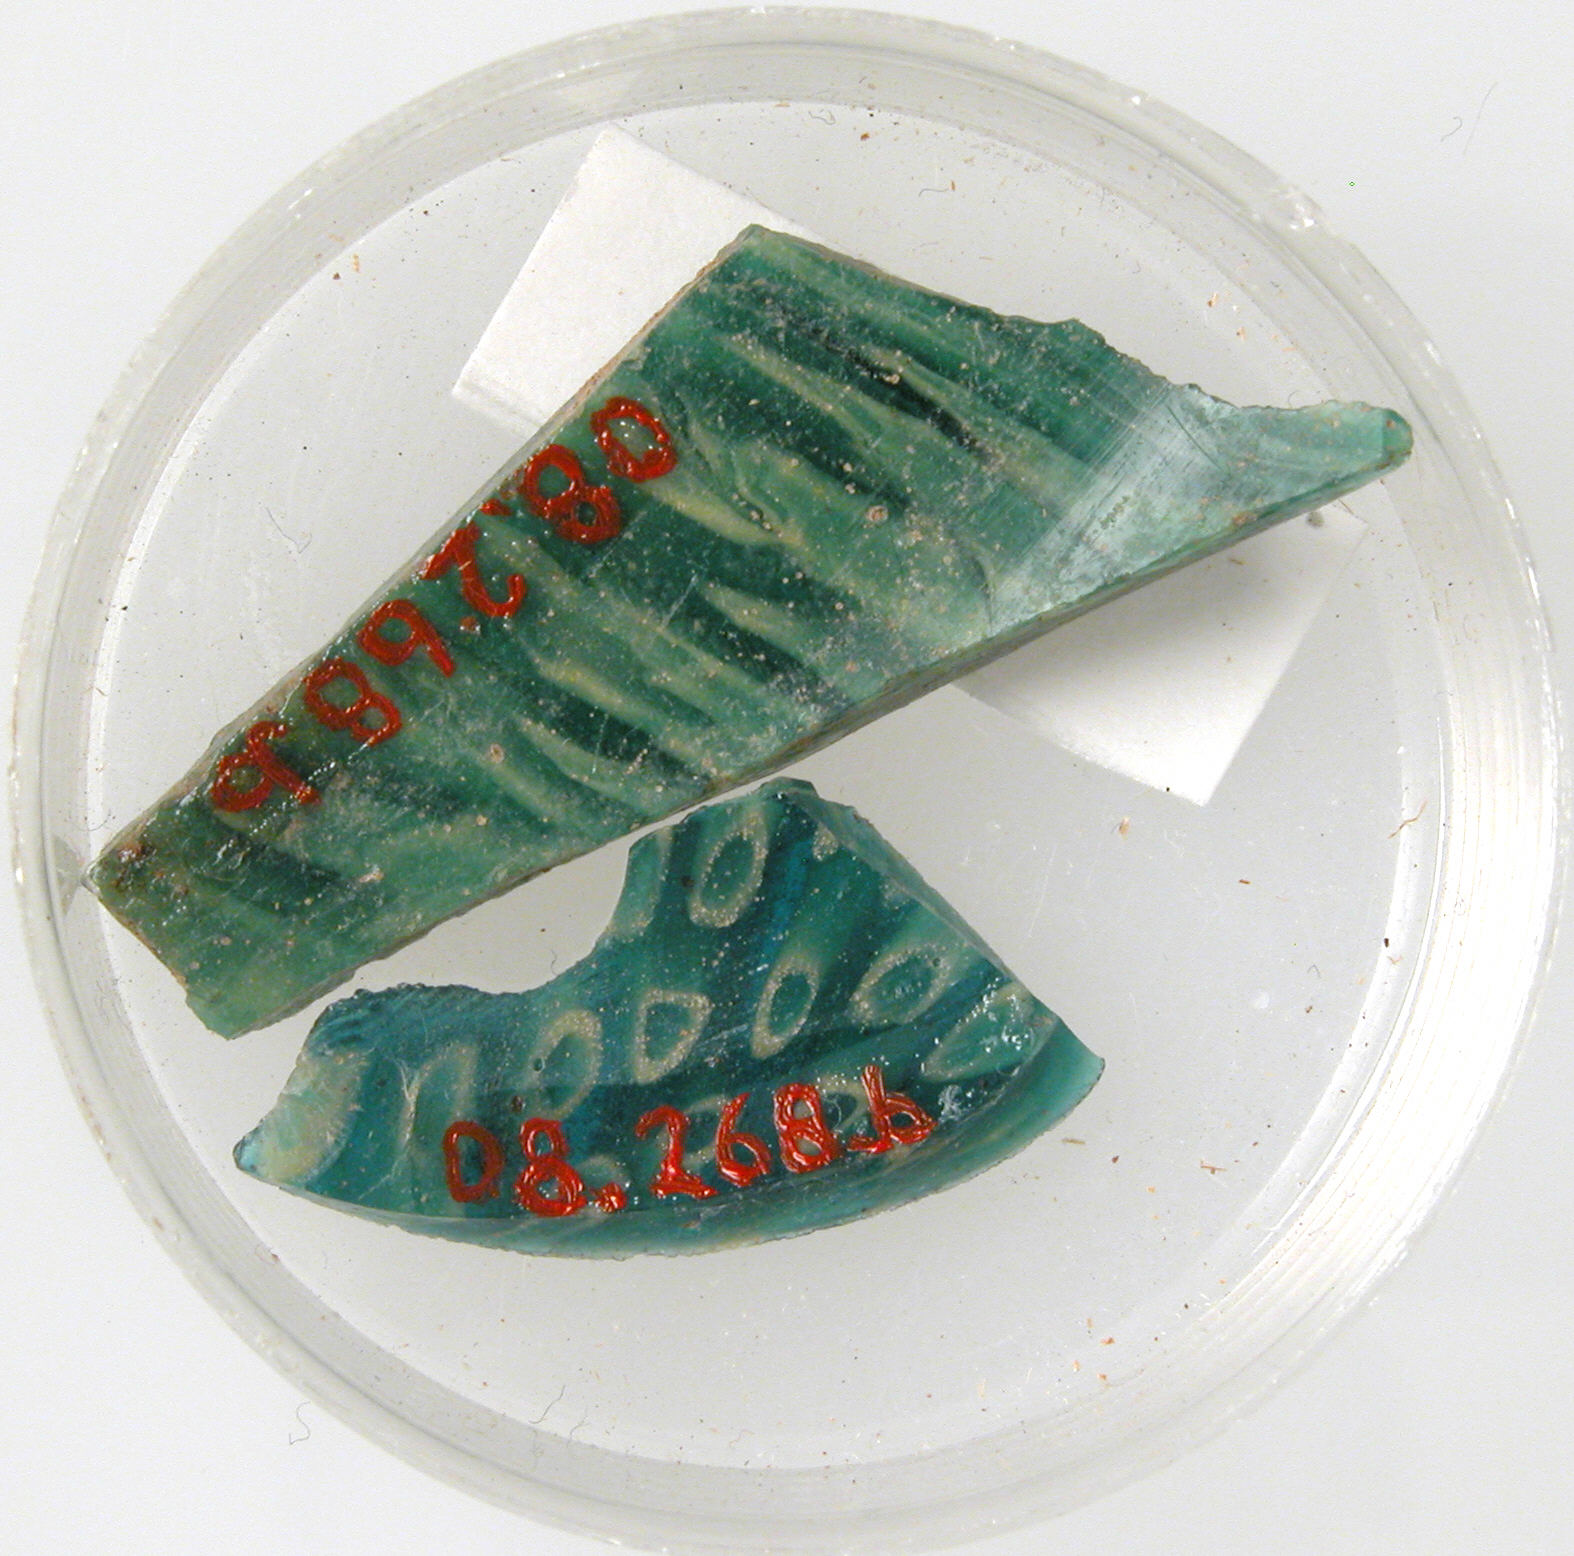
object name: fragment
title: Glass Fragments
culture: coptic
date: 301-433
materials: glass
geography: egypt